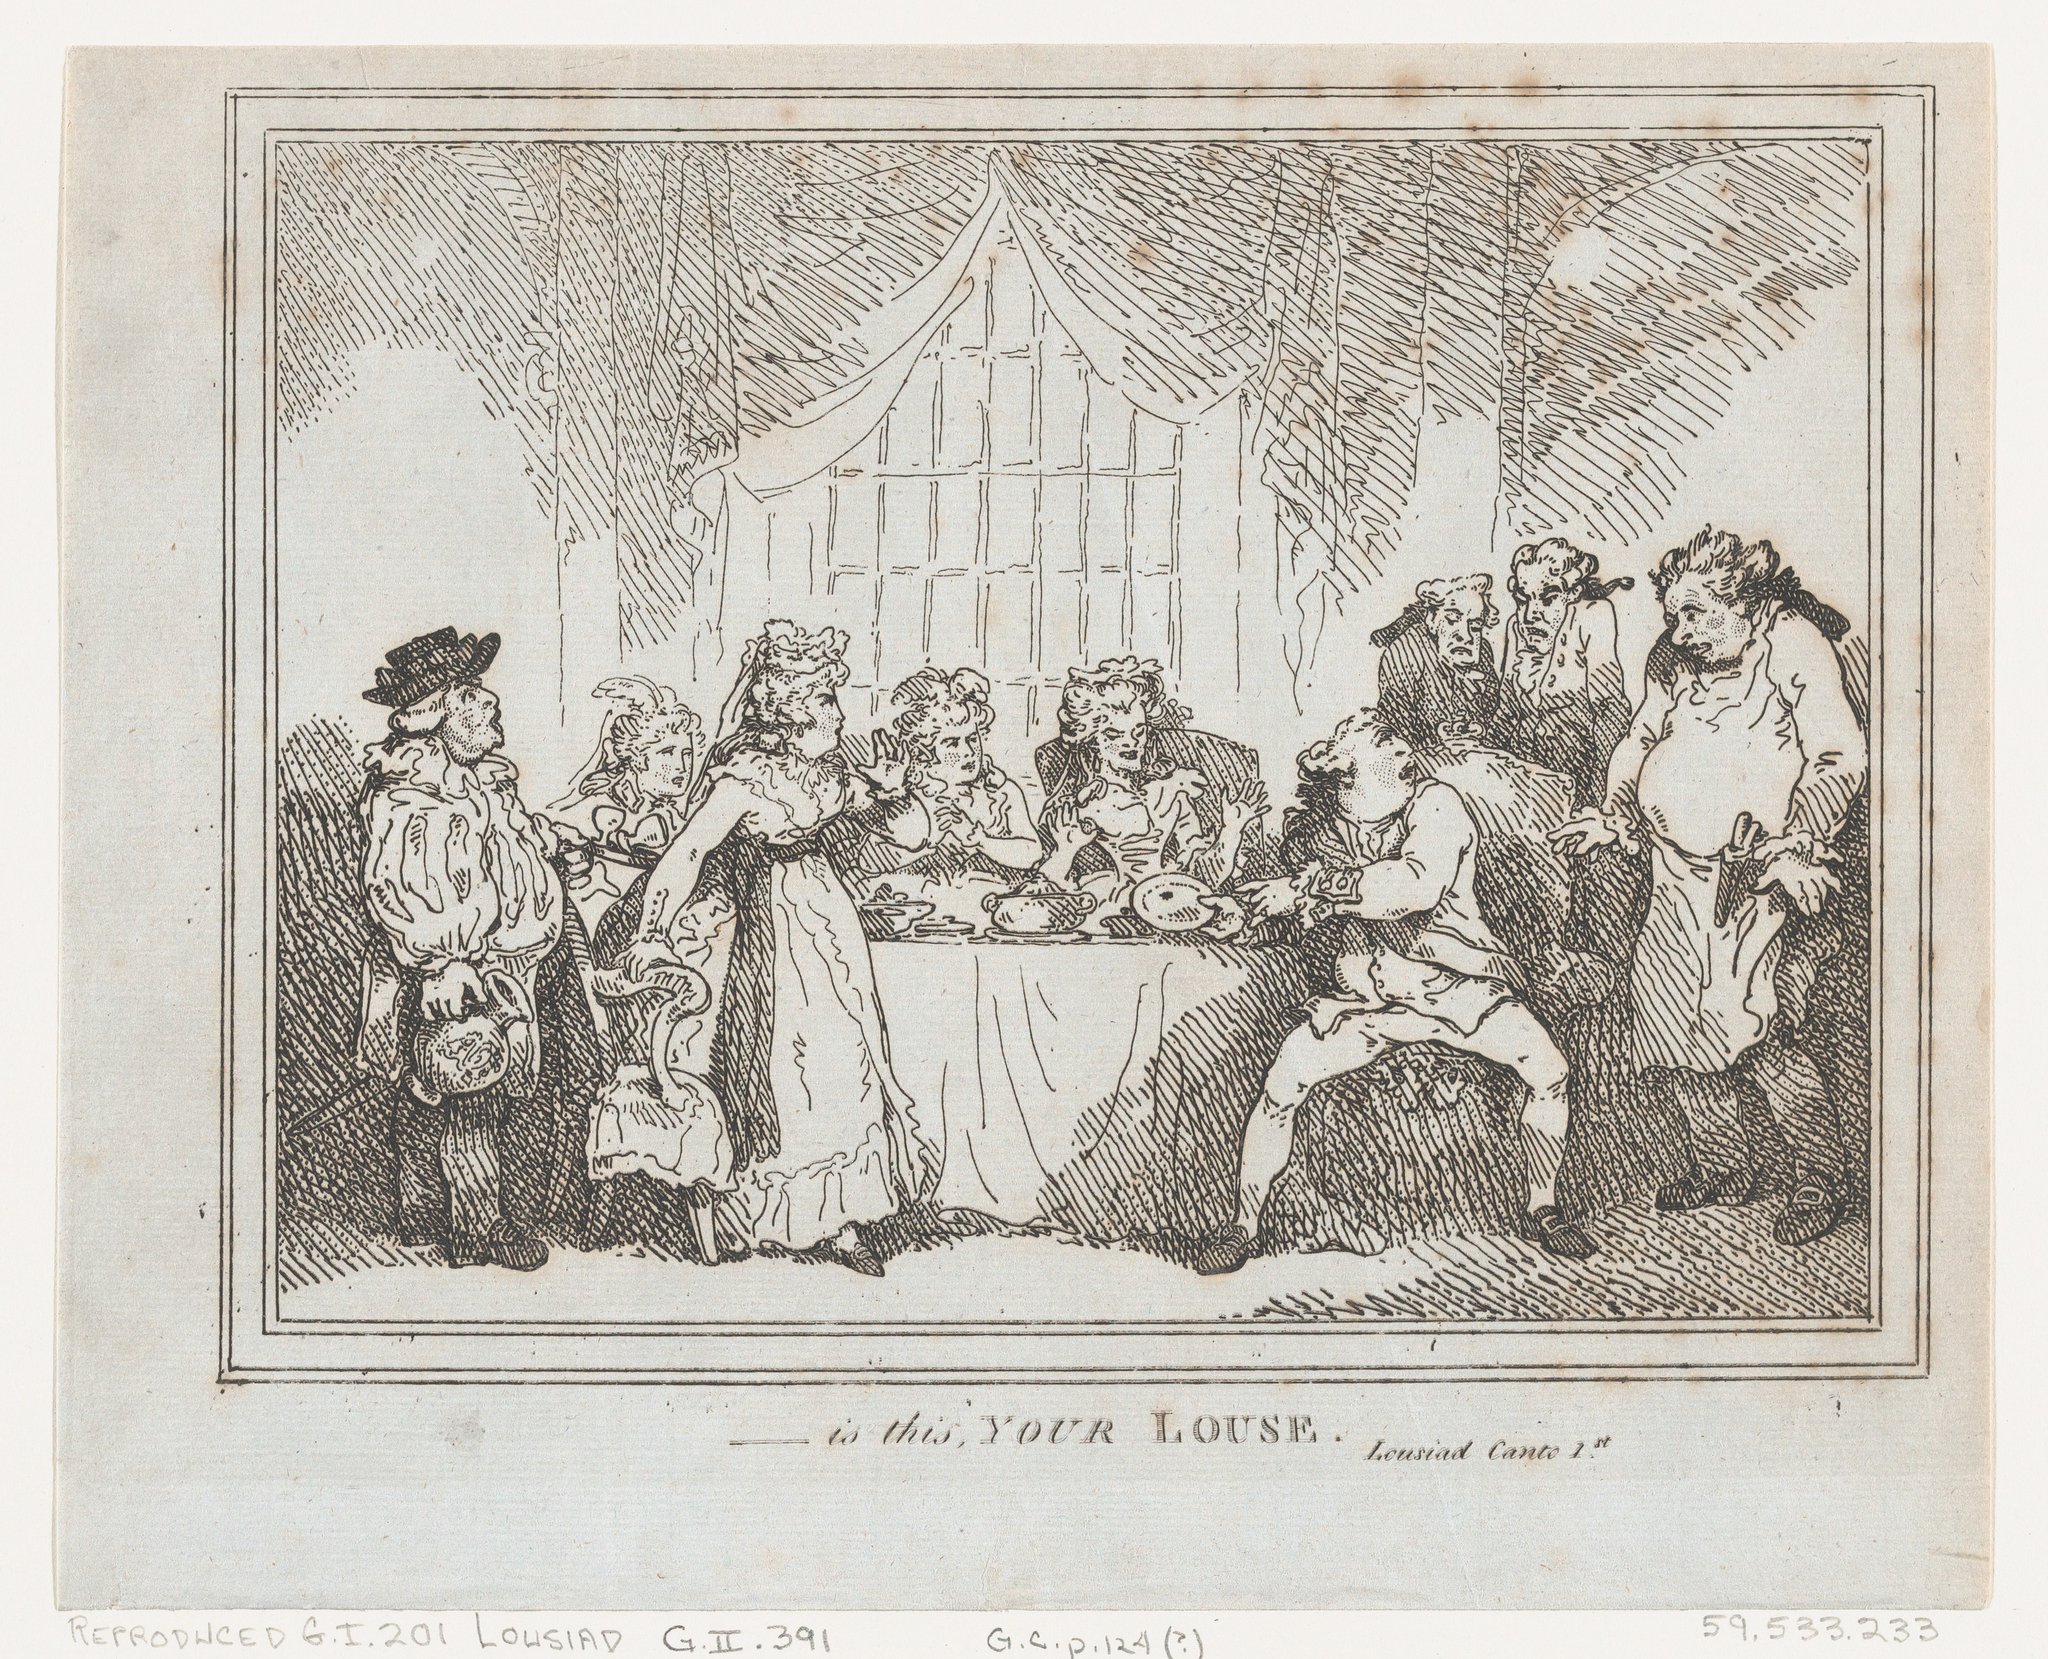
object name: print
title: Is This Your Louse?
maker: thomas rowlandson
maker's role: artist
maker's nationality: british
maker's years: 1757-1827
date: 1787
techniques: etching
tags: men,women